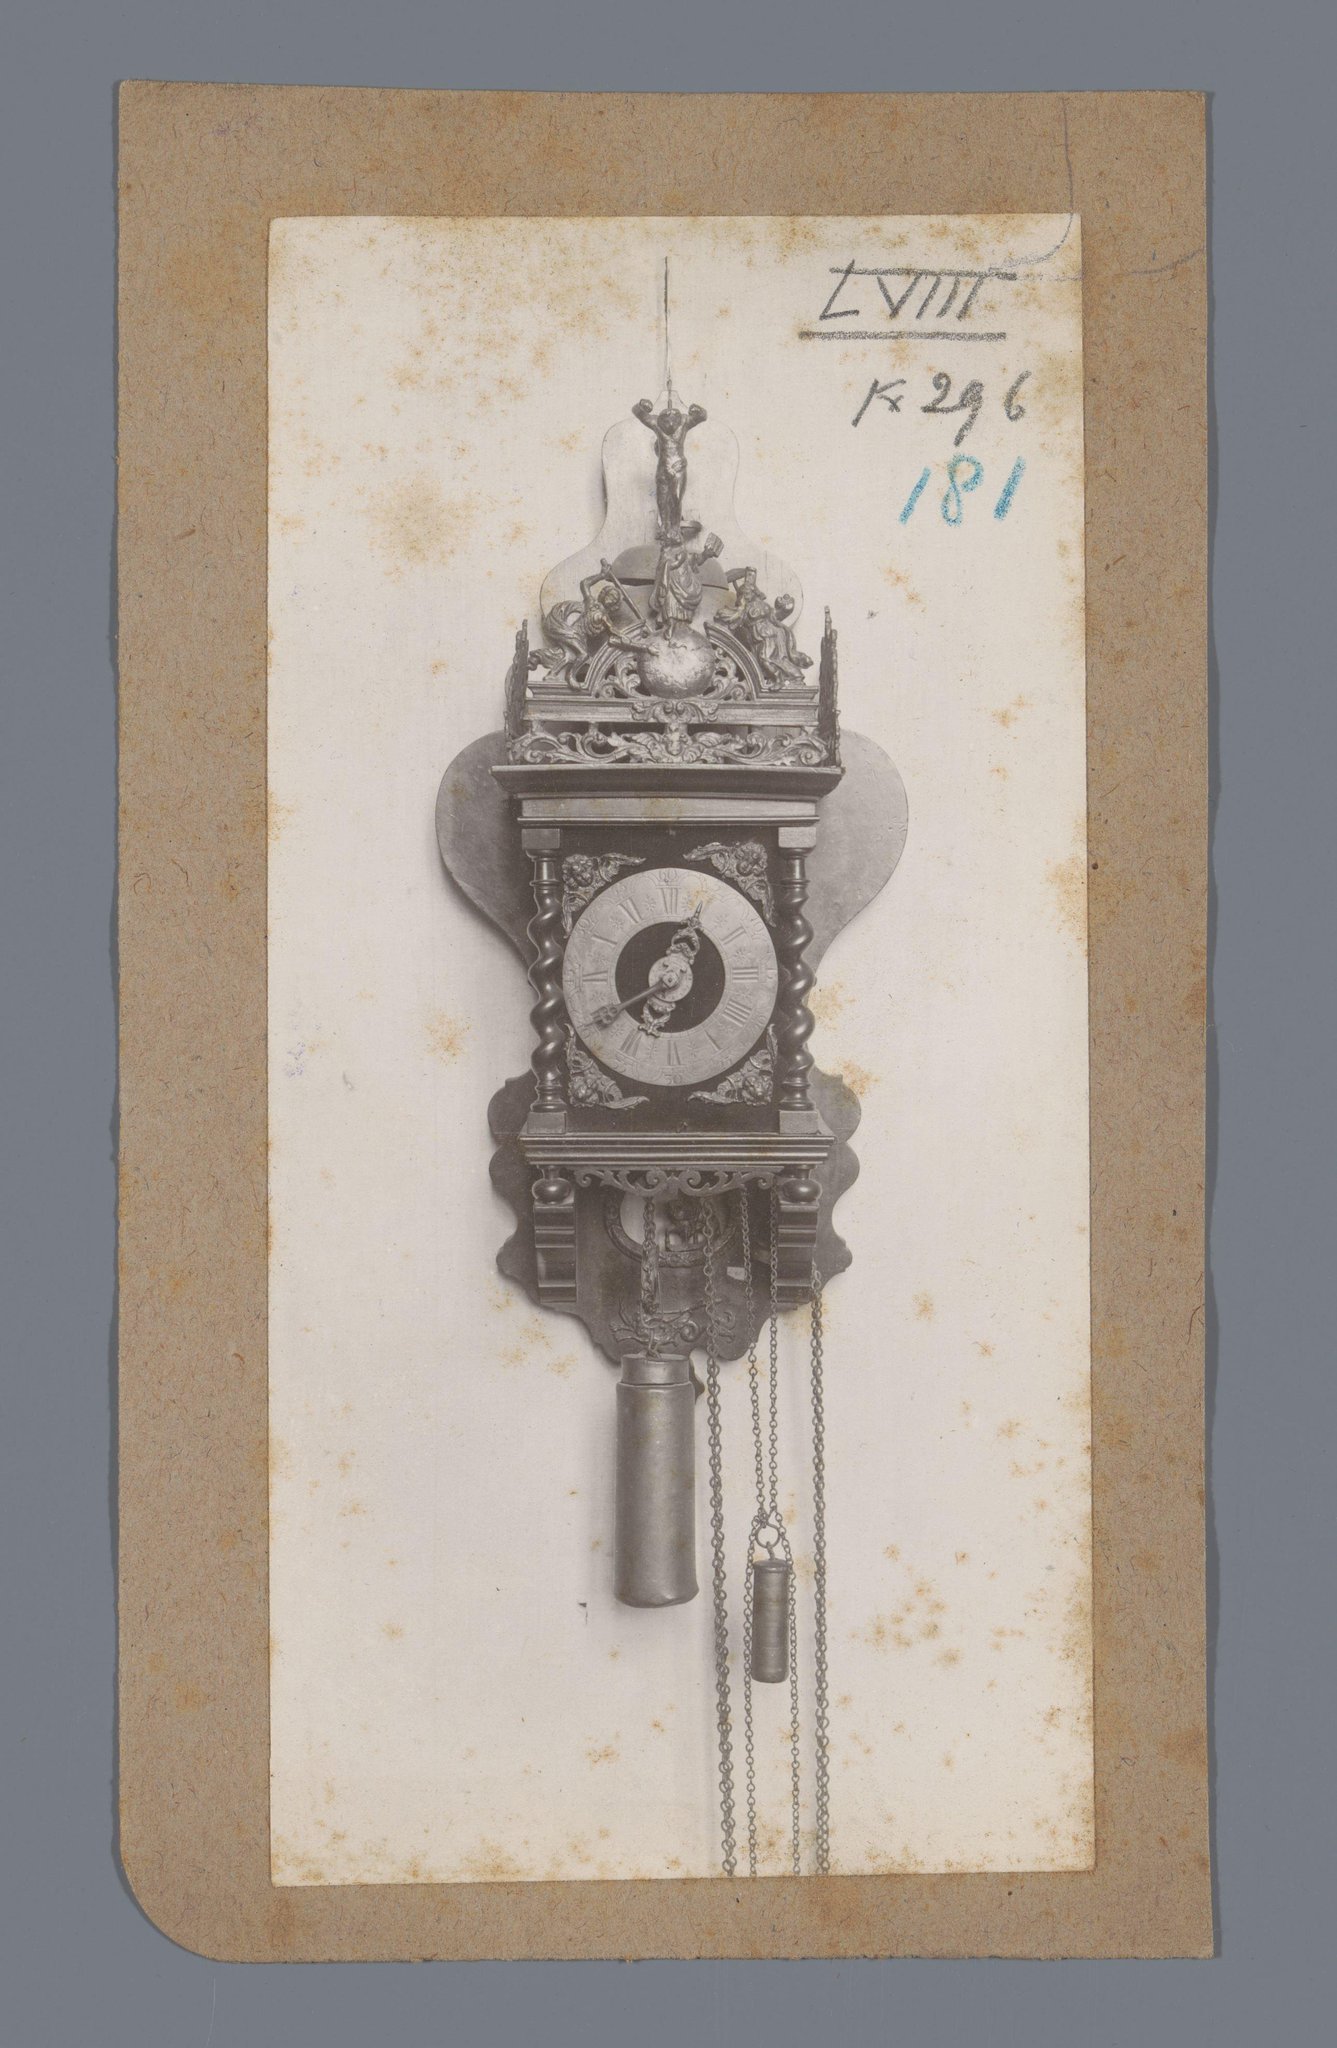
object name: photograph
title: Wandklok gedecoreerd met putti en gedraaide pilasters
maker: Anonymous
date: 1875-1900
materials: photographic support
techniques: matte daylight collodion silver print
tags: column, pillar ~ architecture, clock, cupids: 'amores', 'amoretti', 'putti'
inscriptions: collector's mark: ‘Kunstnijverheidschool Quellinus Amsterdam Frans Halsstraat 14.’, number: ‘LVIII Kat 296 181’, collector's mark: ‘Instituut voor kunst-nijverheidsonderwijs Gabriël Metsustraat No. 16, Amsterdam’